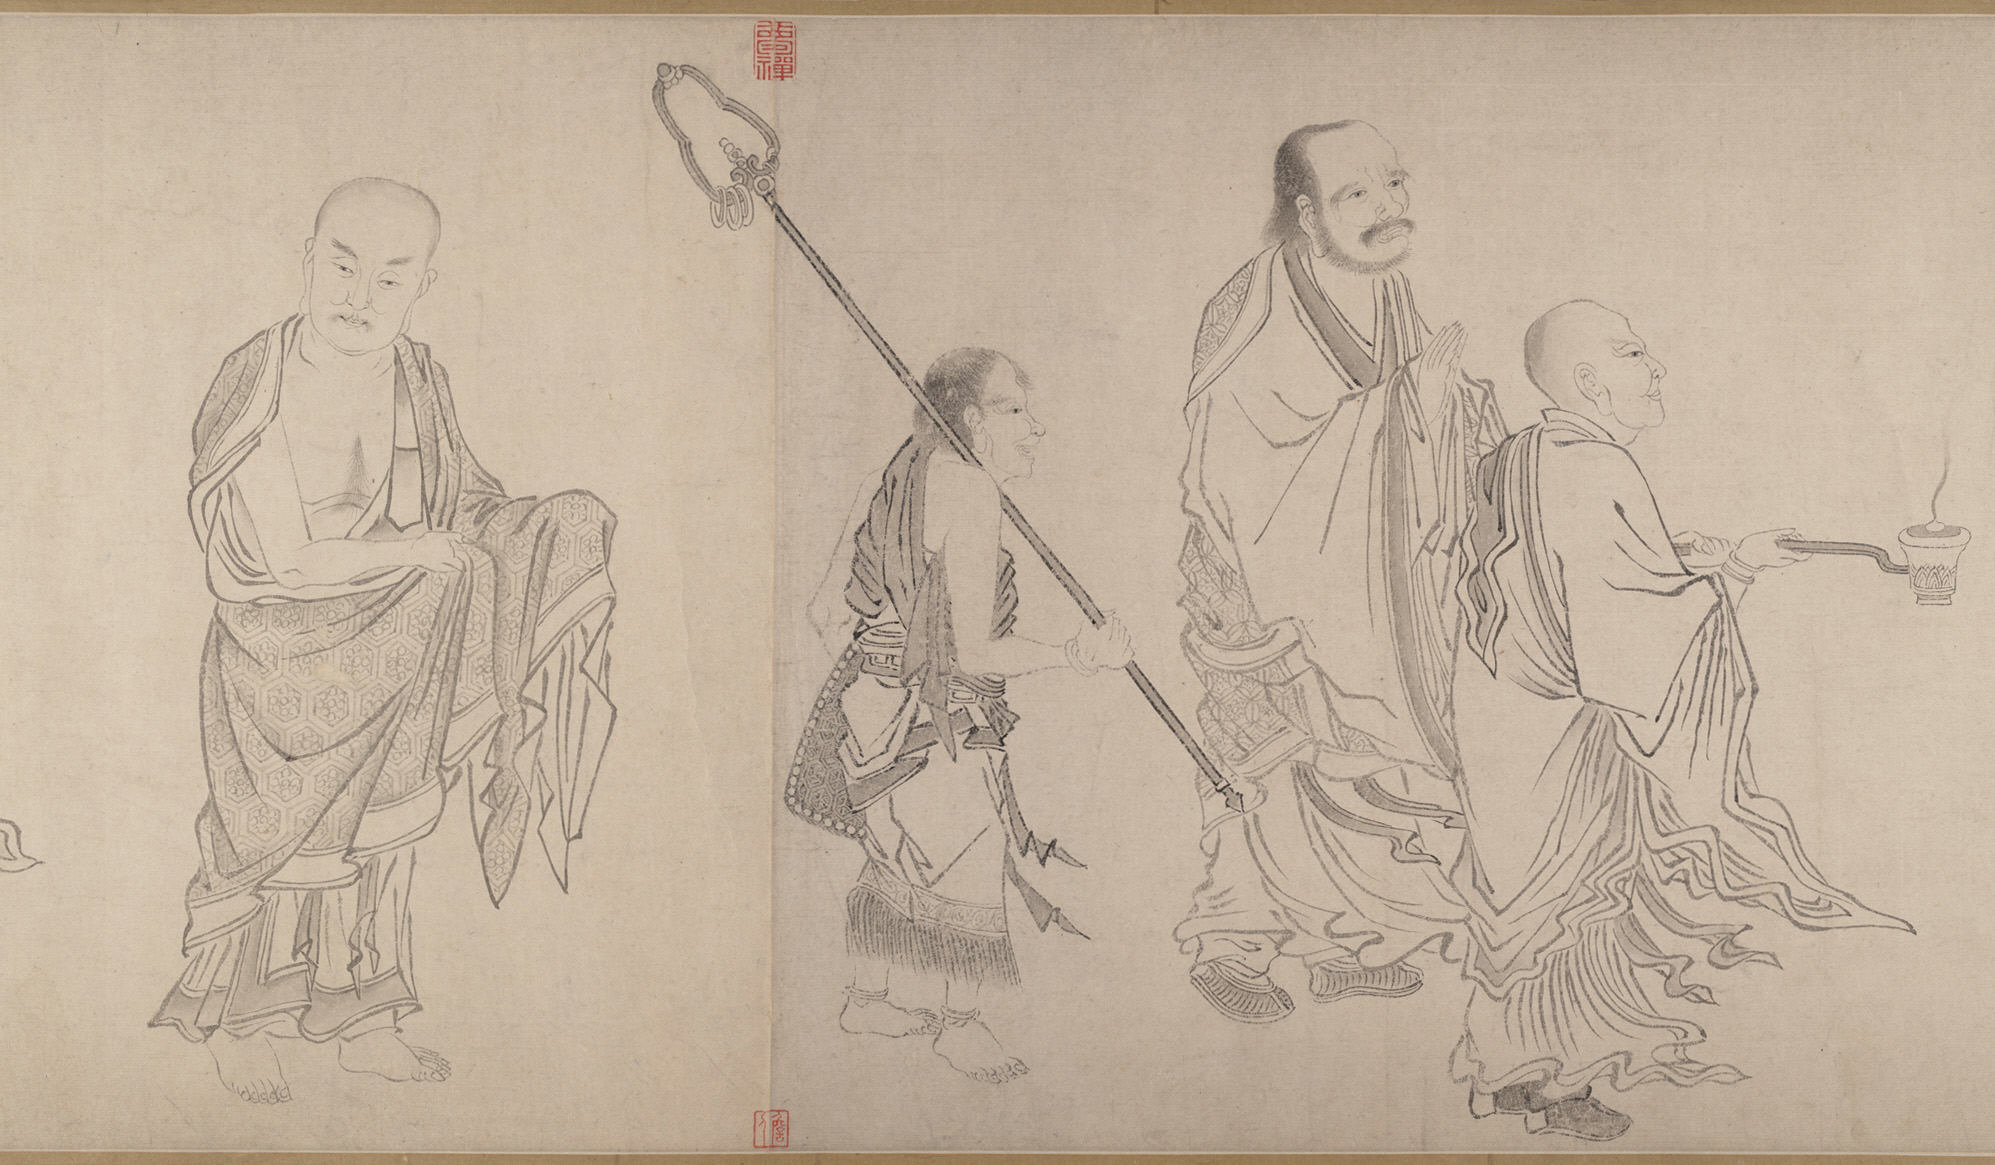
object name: handscroll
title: The Sixteen Luohans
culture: chinese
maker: qiu ying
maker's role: artist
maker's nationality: chinese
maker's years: 1485-1562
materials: ink, paper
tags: buddhism,monks